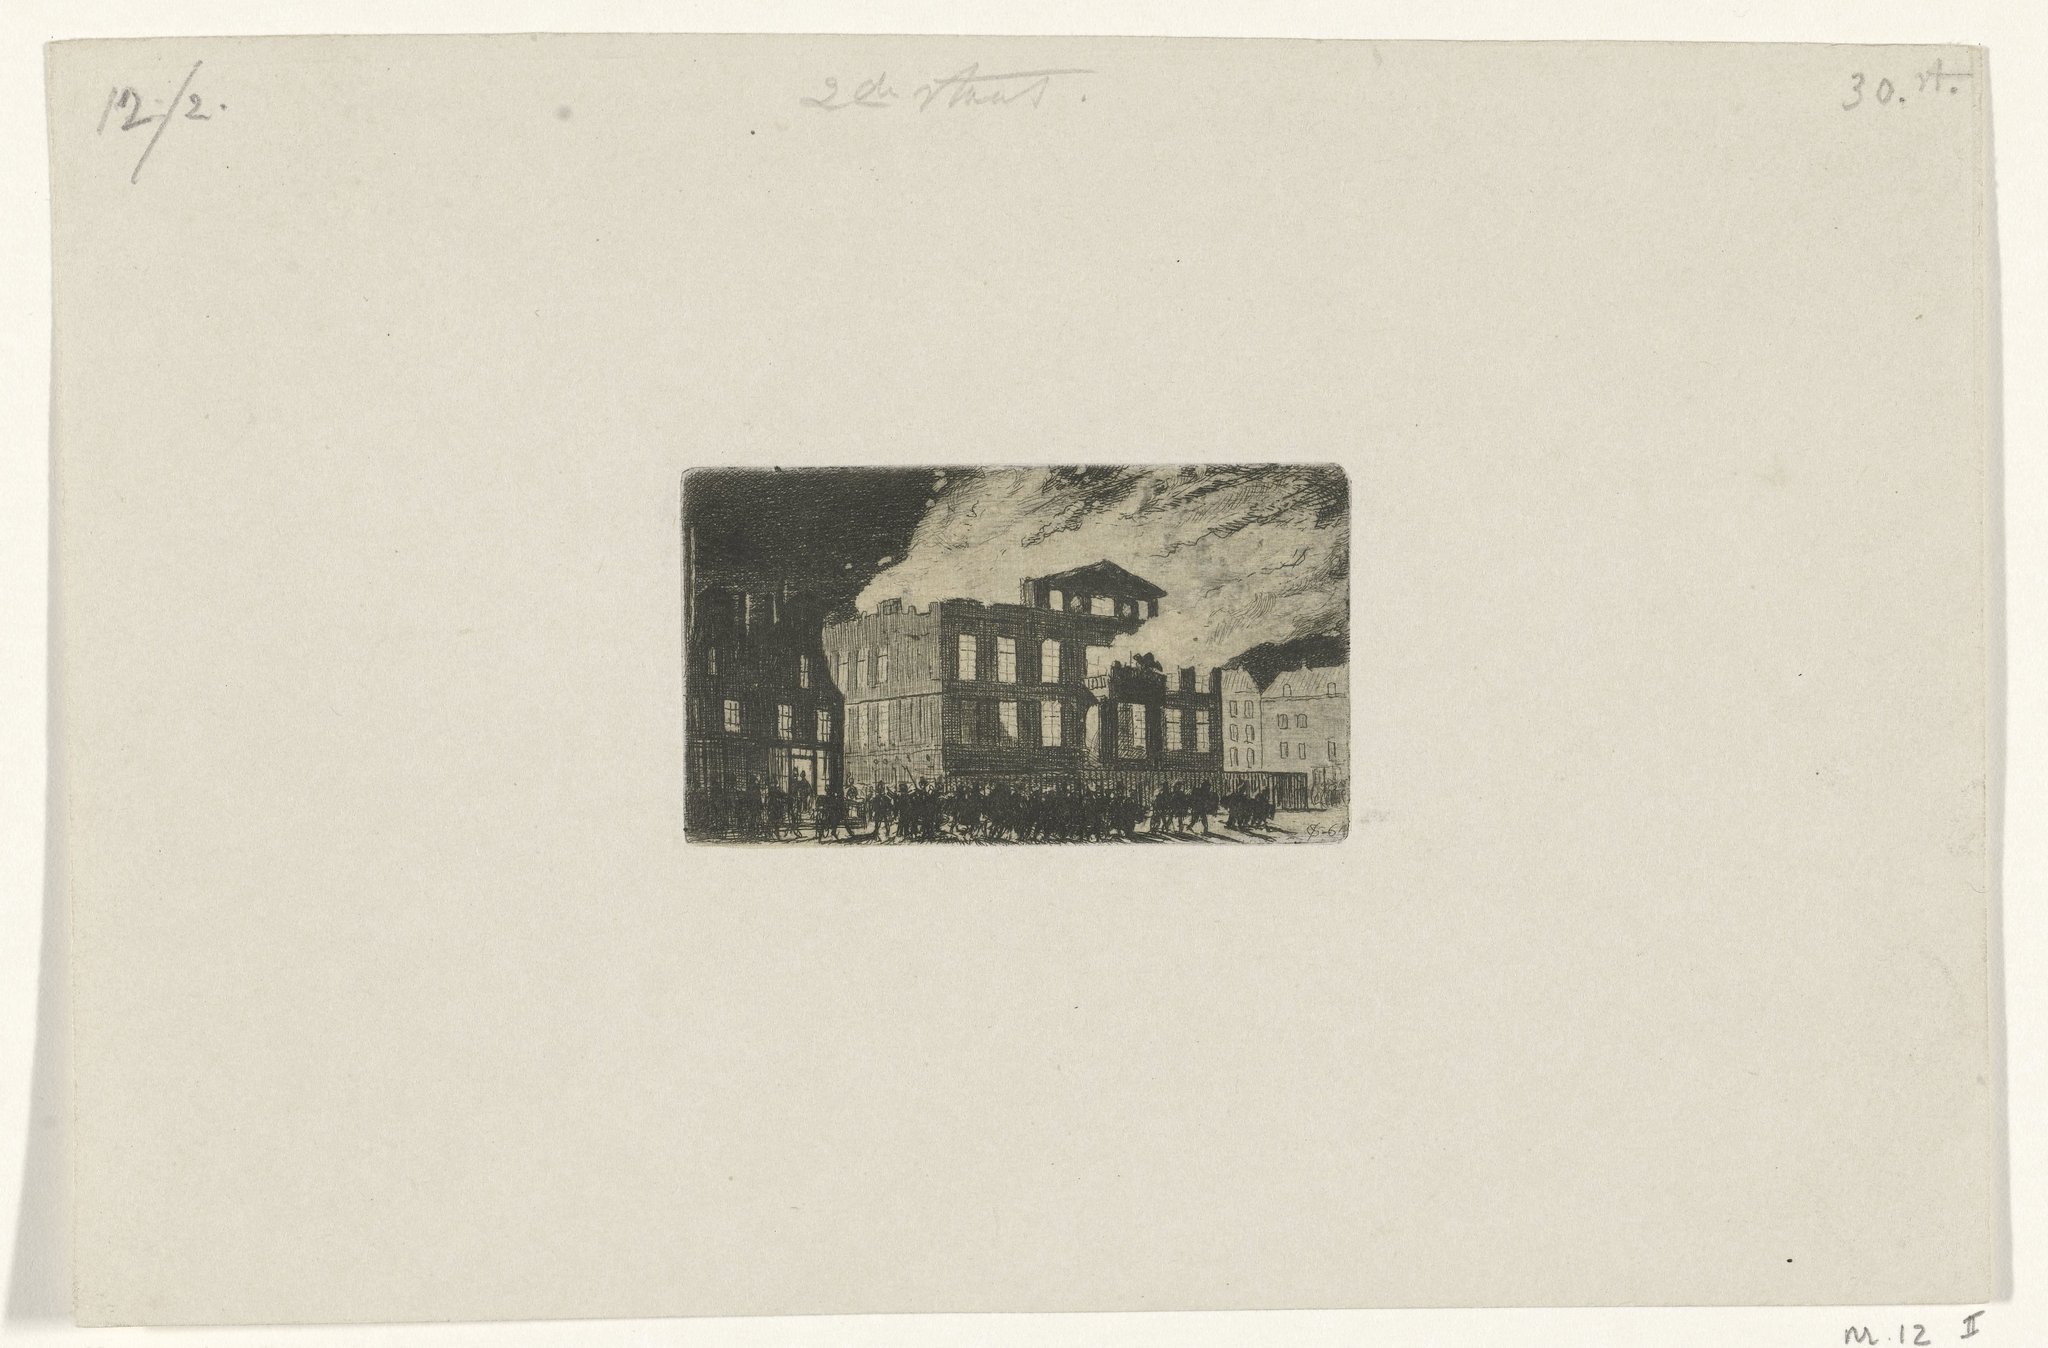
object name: print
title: Brand in Museum Boijmans, 1864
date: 1864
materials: paper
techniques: etching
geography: rotterdam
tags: on fire, ablaze, rotterdam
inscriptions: collector's mark: Lugt 2228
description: Brand in Museum Boijmans in de nacht van 15 op 16 februari 1864.